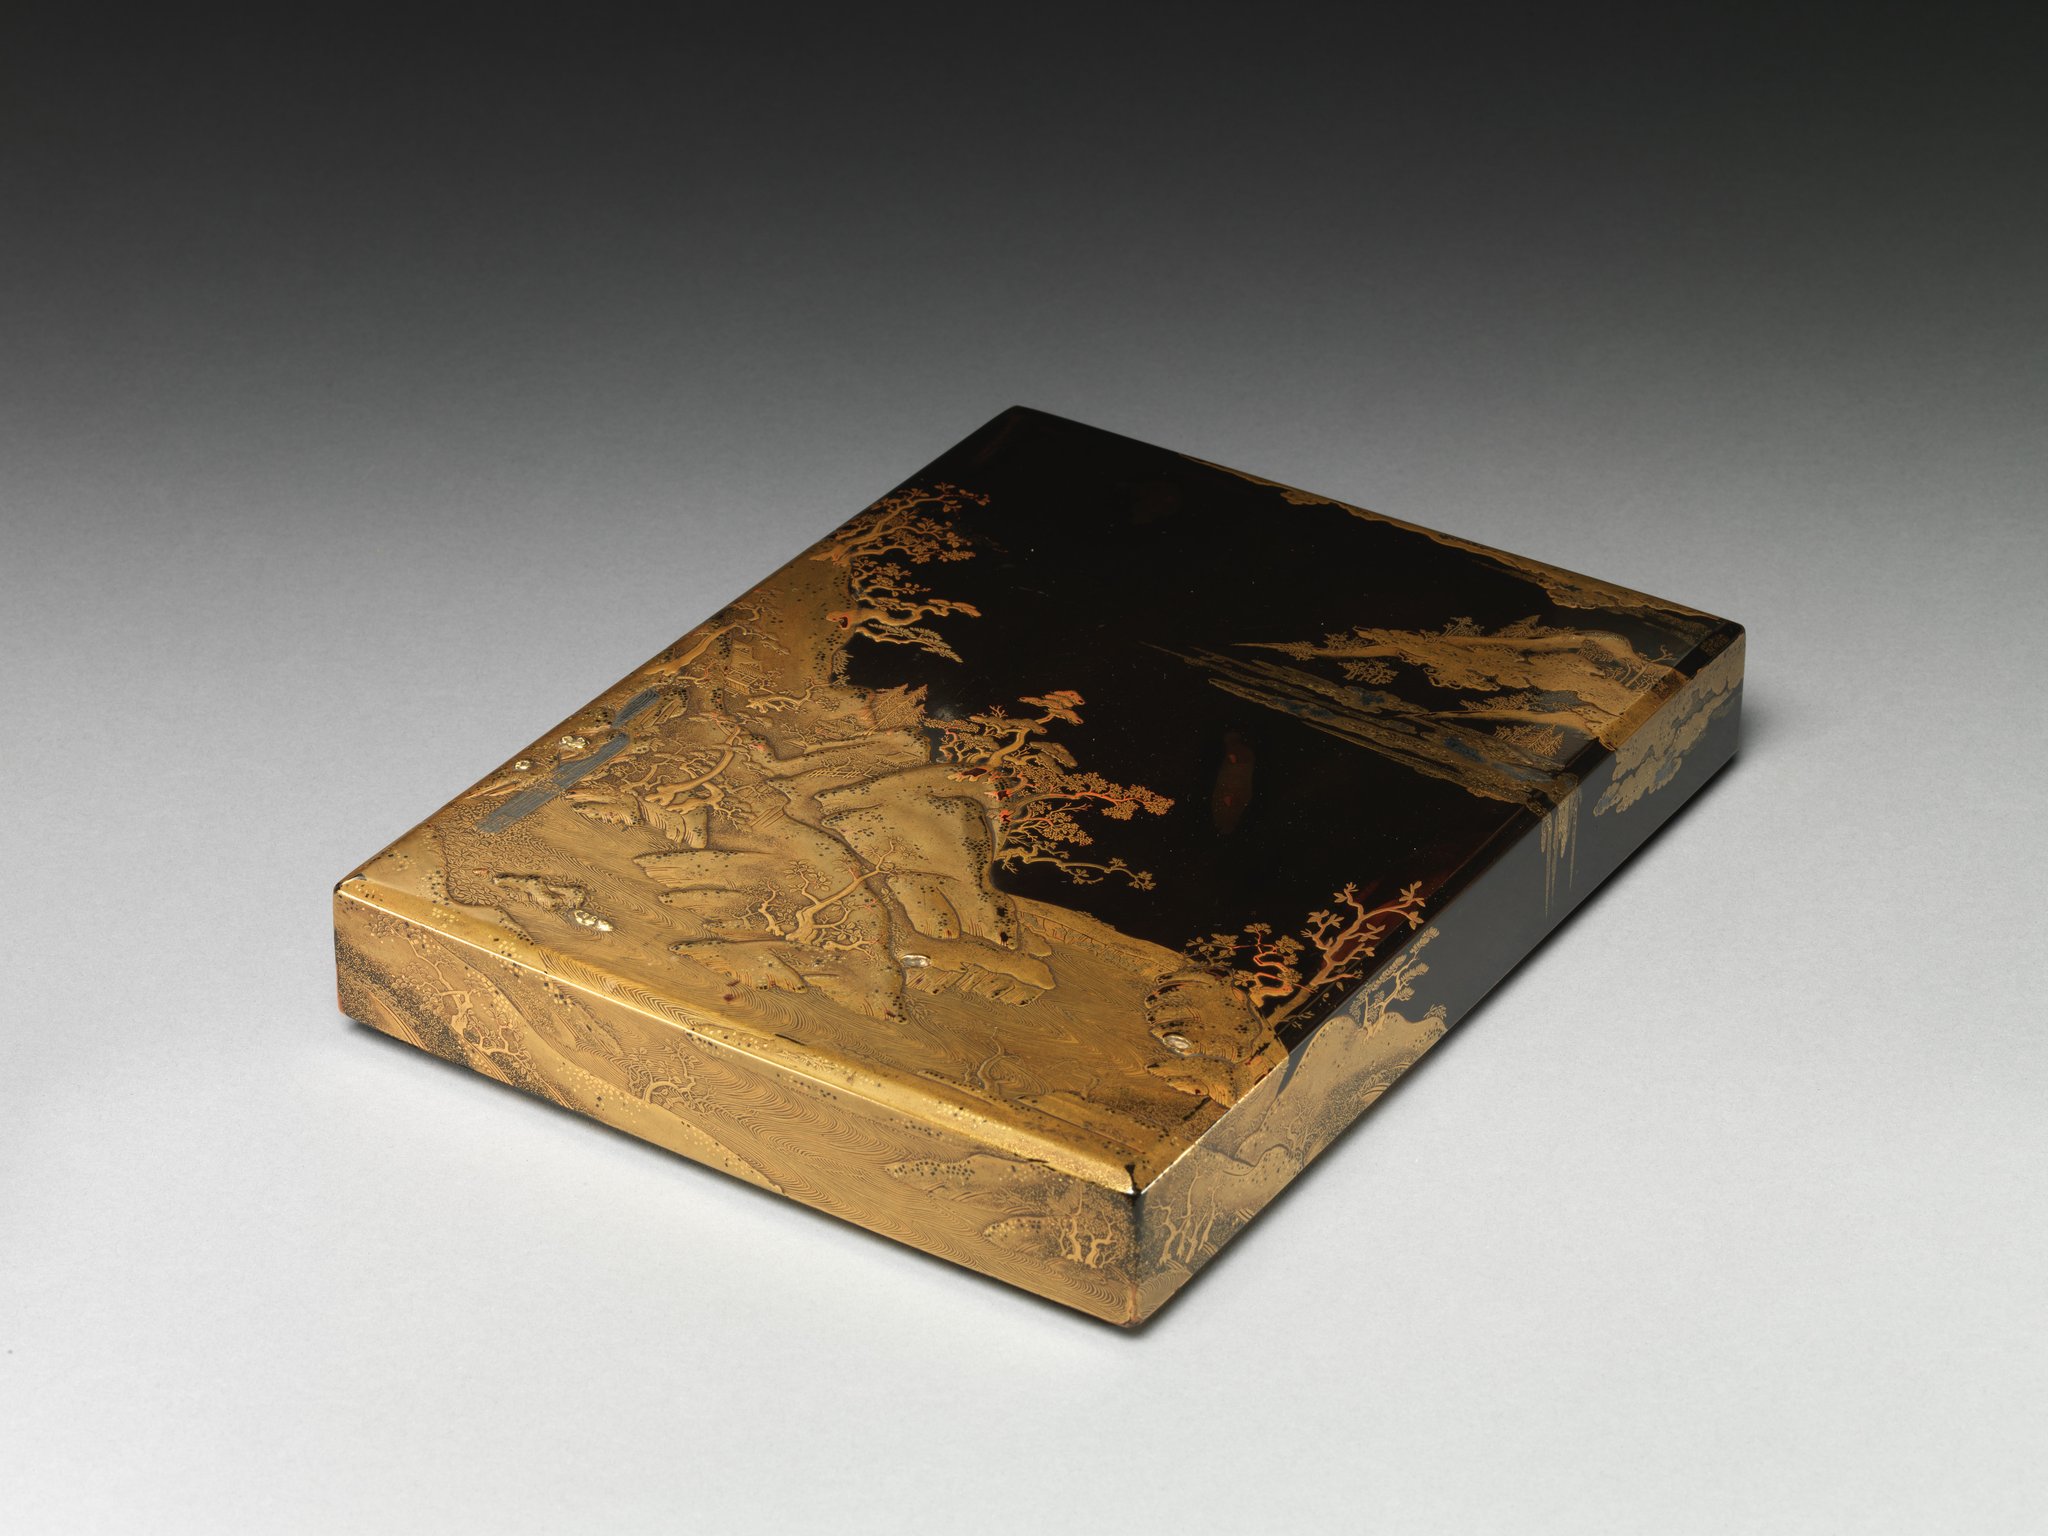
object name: book box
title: Box for Books with Waterfall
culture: japanese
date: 1501-1600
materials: foil, gold, lacquer, silver, wood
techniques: cutting, hiramakie, inlay, lacquer, maki-e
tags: waterfalls,trees